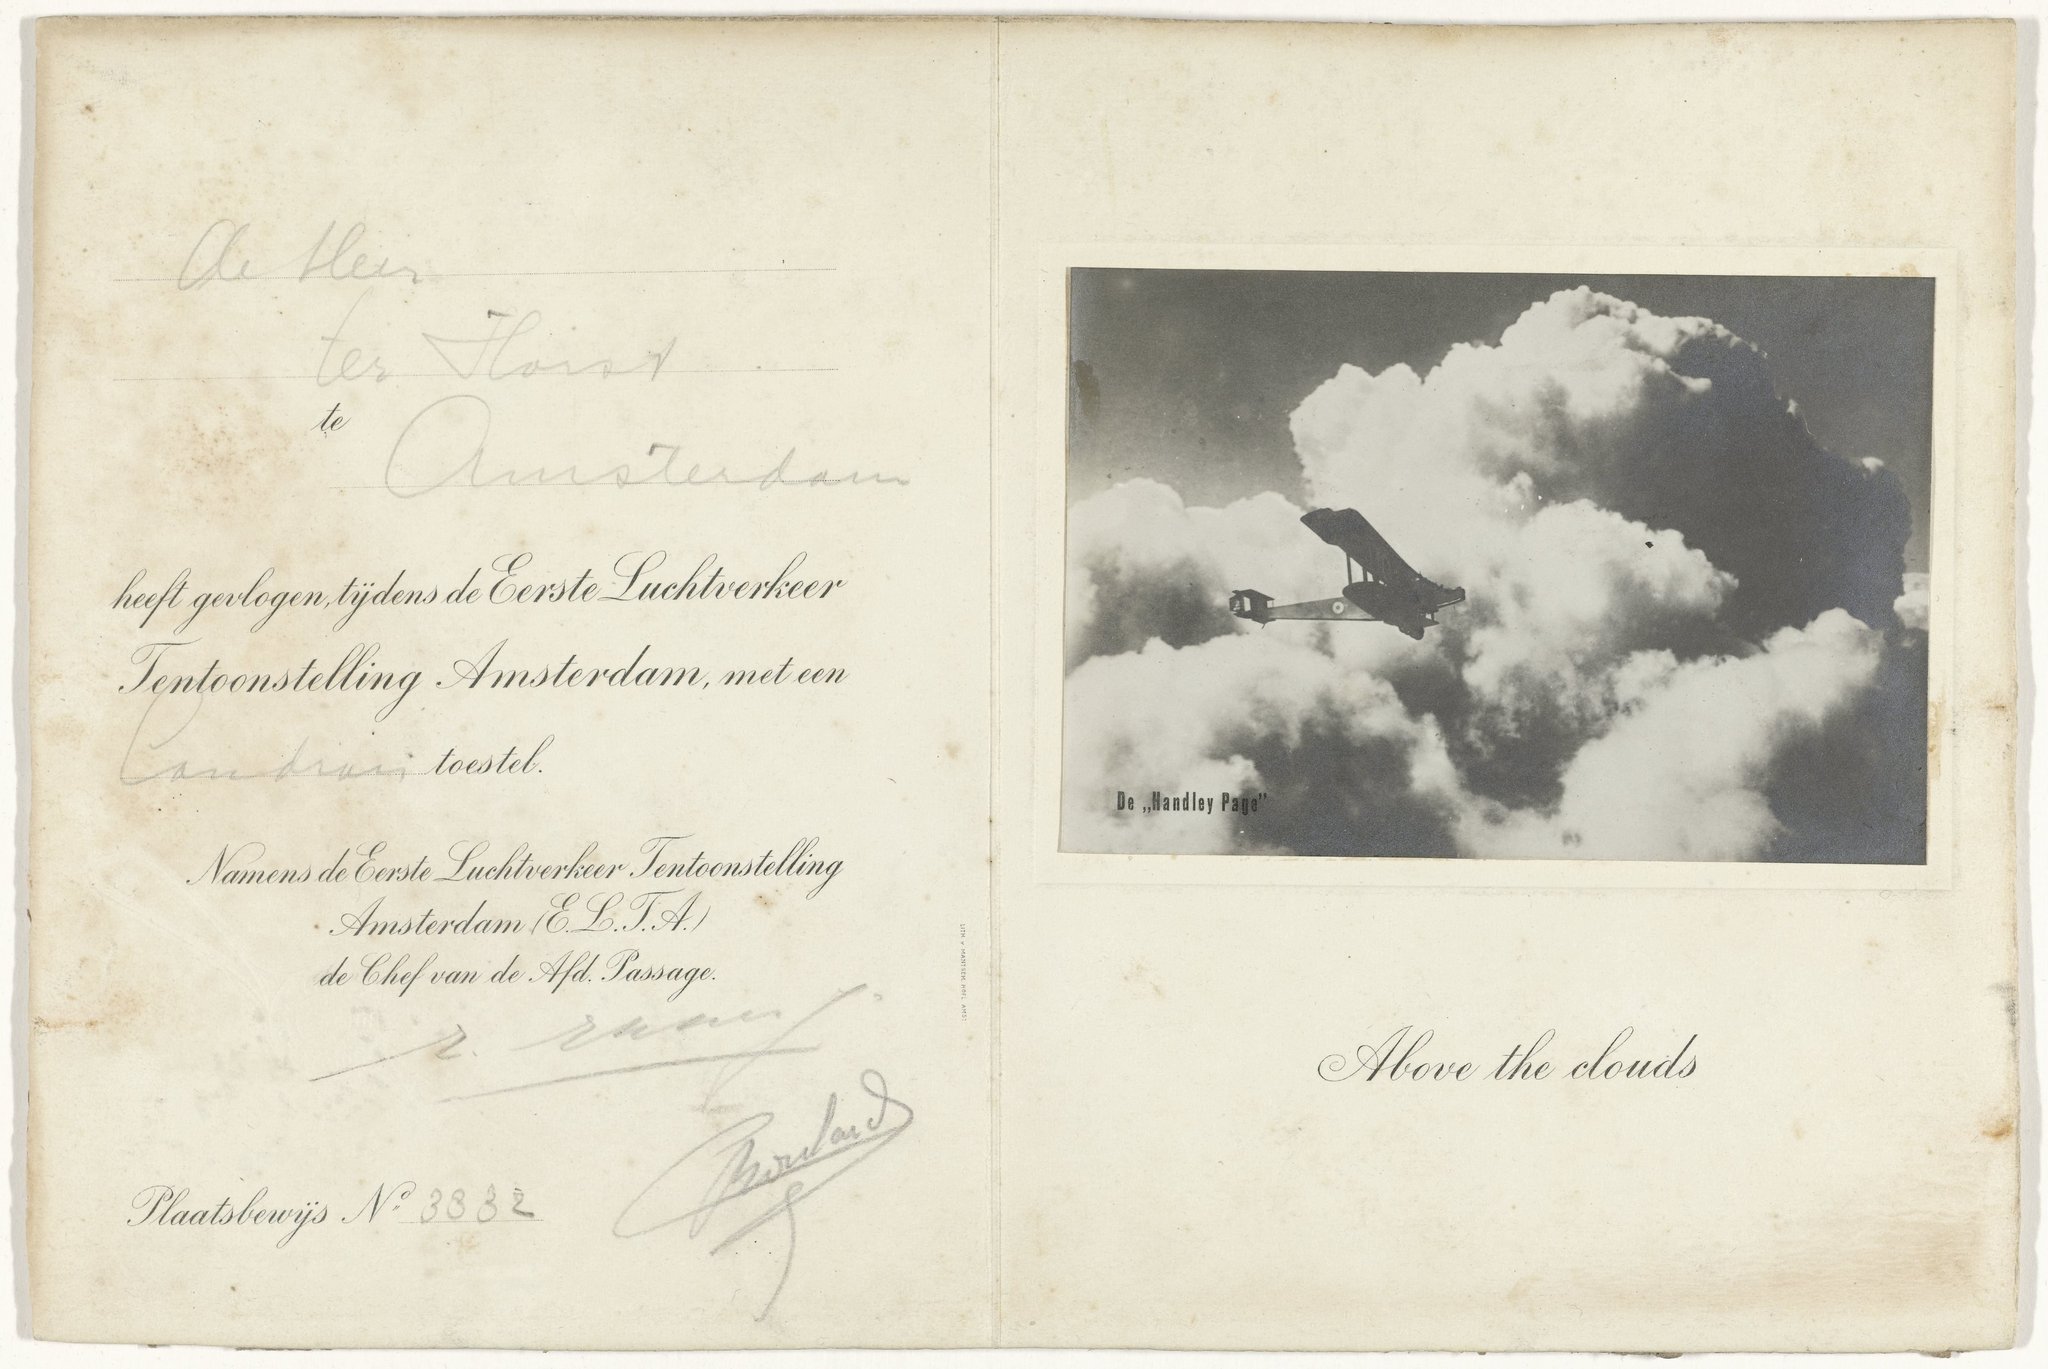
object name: photograph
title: De 'Handley Page'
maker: Anonymous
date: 1916-1919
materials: cardboard, photographic support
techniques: gelatin silver print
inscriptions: annotation: ‘De heer ter Horst te Amsterdam heeft gevlogen tijdens de Eerste Luchtverkeer Tentoonstelling Amsterdam...’, label: ‘Wed. C.D. Fetter & Zonen. Spiegel fabrikanten engadreurs vergulders. Gasthuismolensteeg 5 Amsterdam’